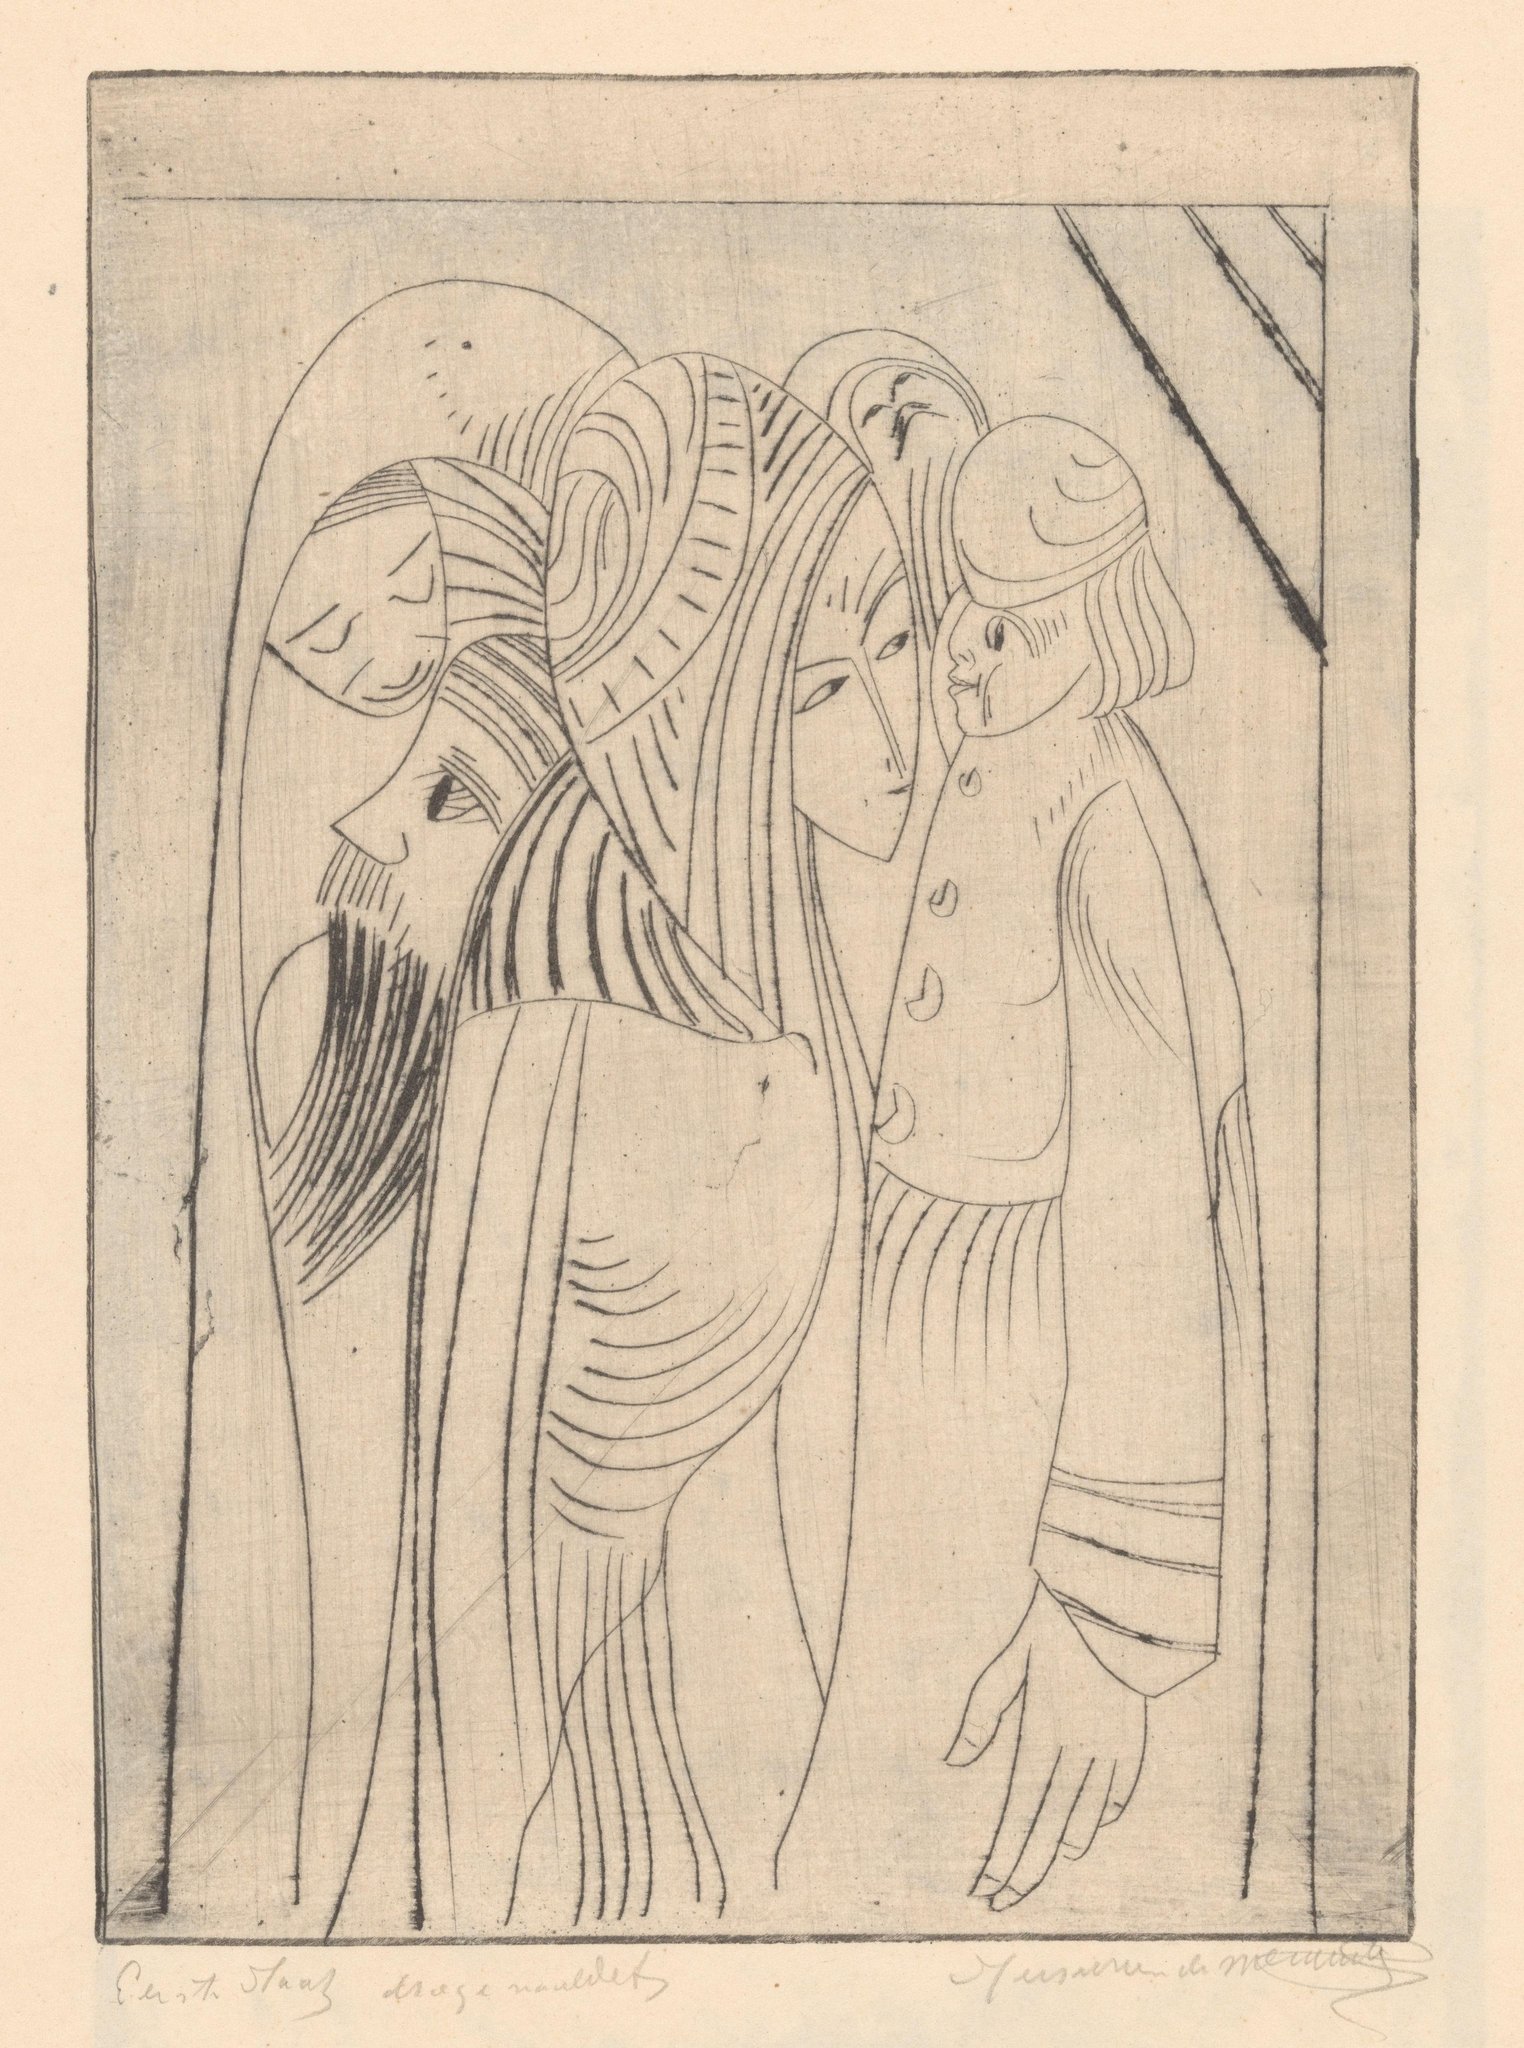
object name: print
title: Fantasie: groep figuren, in het midden een vrouw met puntige kin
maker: samuel jessurun de mesquita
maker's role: draughtsman, print maker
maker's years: 1868-1944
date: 1924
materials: paper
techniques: drypoint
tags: caricatures (human types), beard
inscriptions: collector's mark: Lugt 2228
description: Links een figuur met een baard; rechts een figuur met een bolle hoed. Rechtsboven drie schuine lijnen.